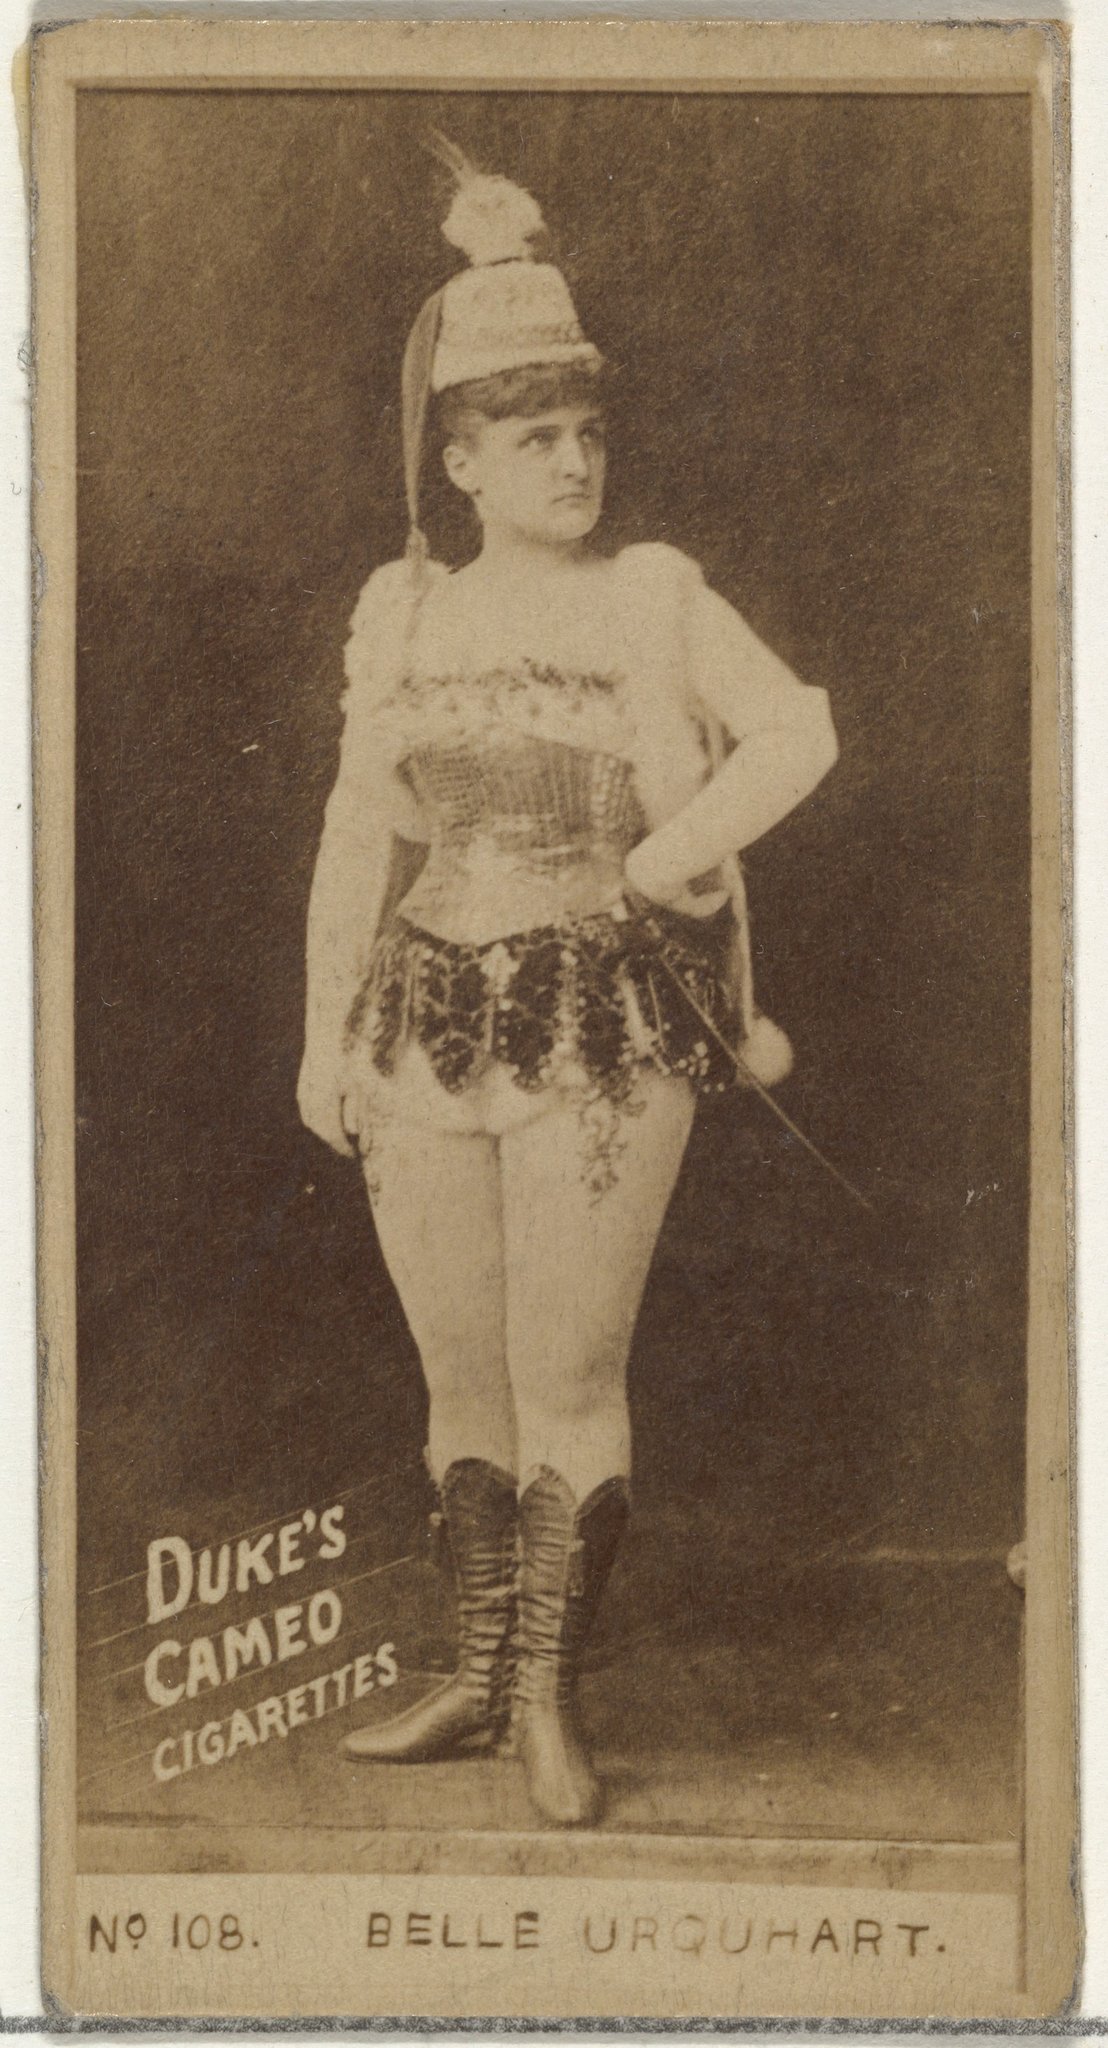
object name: photograph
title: Card Number 108, Belle Urquhart, from the Actors and Actresses series (N145-4) issued by Duke Sons & Co. to promote Cameo Cigarettes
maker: w. duke, sons & co.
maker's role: publisher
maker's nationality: american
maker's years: 1870-1920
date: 1880-1889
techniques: albumen silver print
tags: portraits,women,actresses